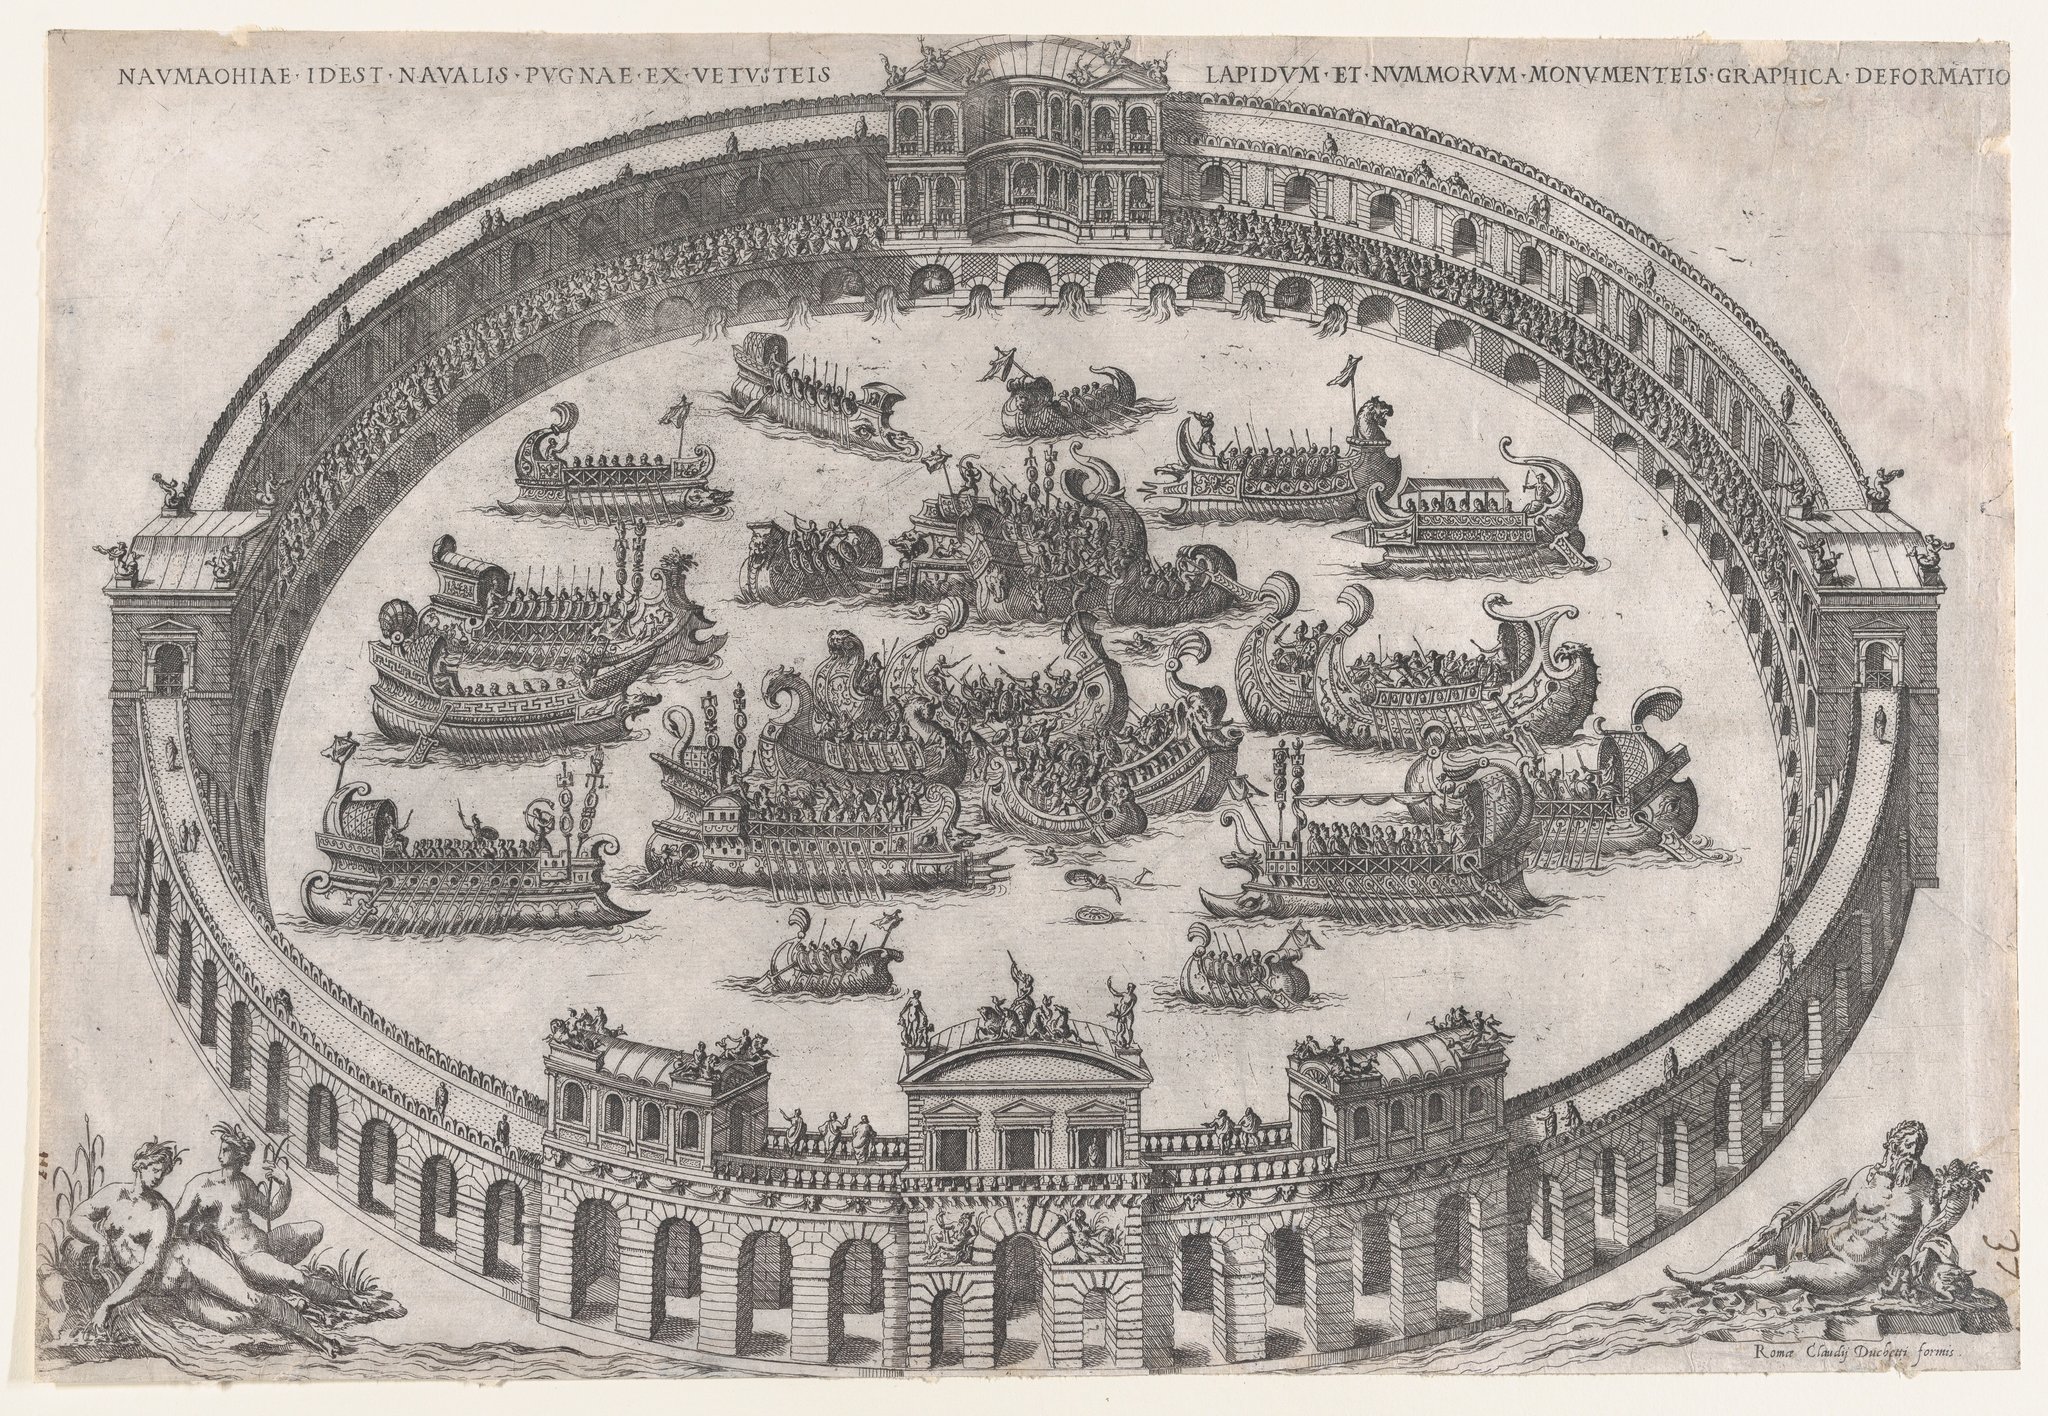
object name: print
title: Roman Naval Battle, from "Speculum Romanae Magnificentiae"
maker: Anonymous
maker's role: artist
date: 1567-1600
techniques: engraving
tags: battles,navy,ships,rome